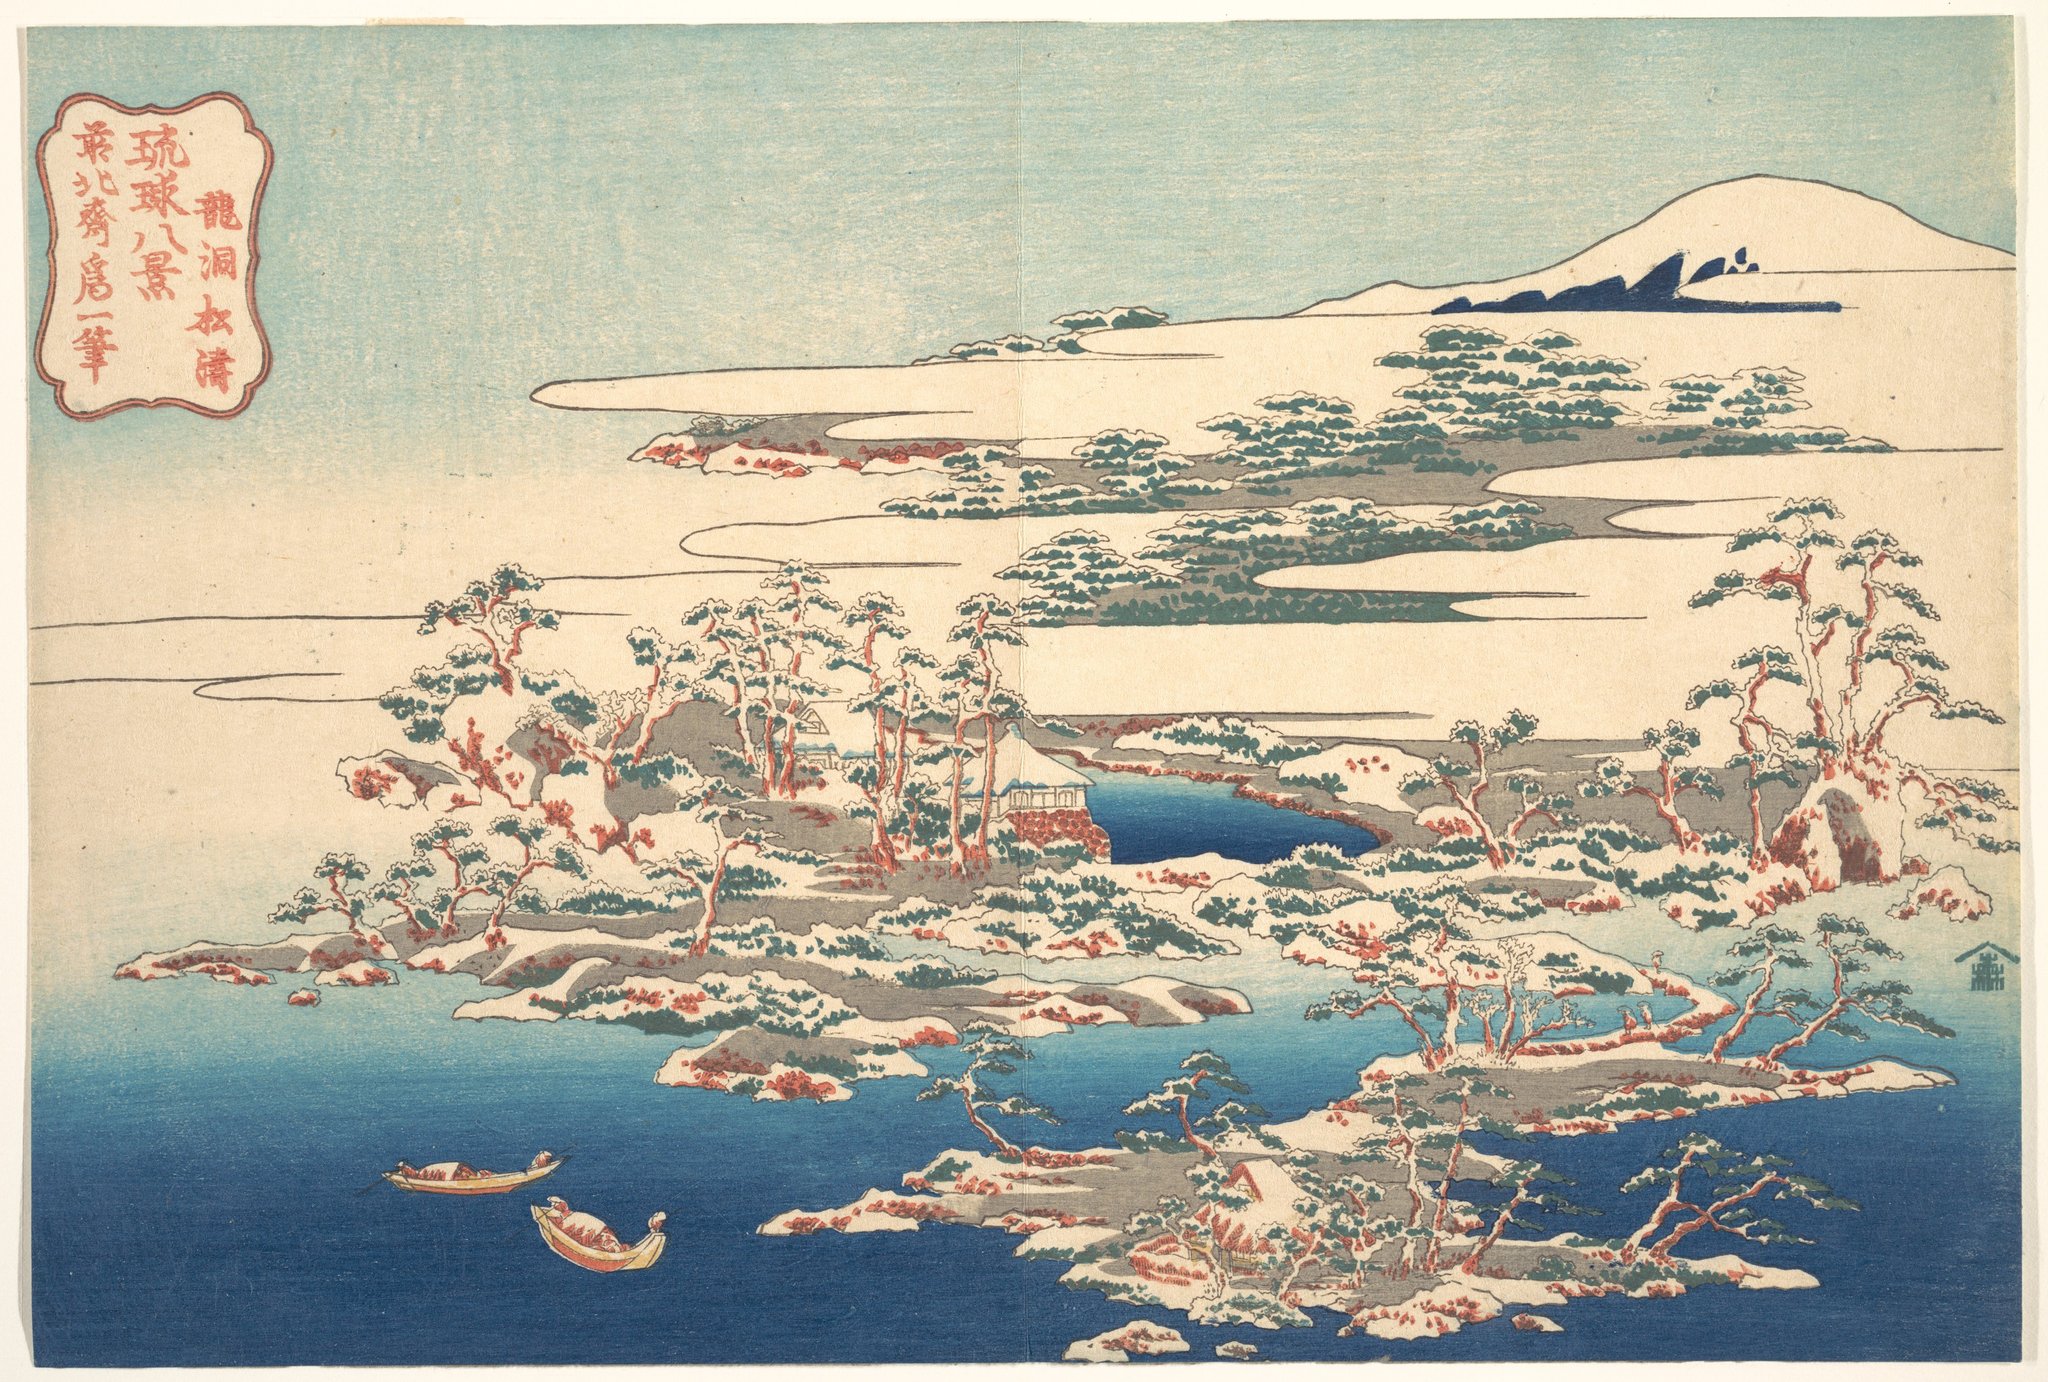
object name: woodblock print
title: Pines and Waves at Ryūtō (Ryūtō shōtō), from the series Eight Views of the Ryūkyū Islands (Ryūkyū hakkei)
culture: japanese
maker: katsushika hokusai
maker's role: artist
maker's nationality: japanese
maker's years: 1760-1849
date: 1832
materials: ink, paper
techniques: woodblock print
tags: landscapes,snow,islands